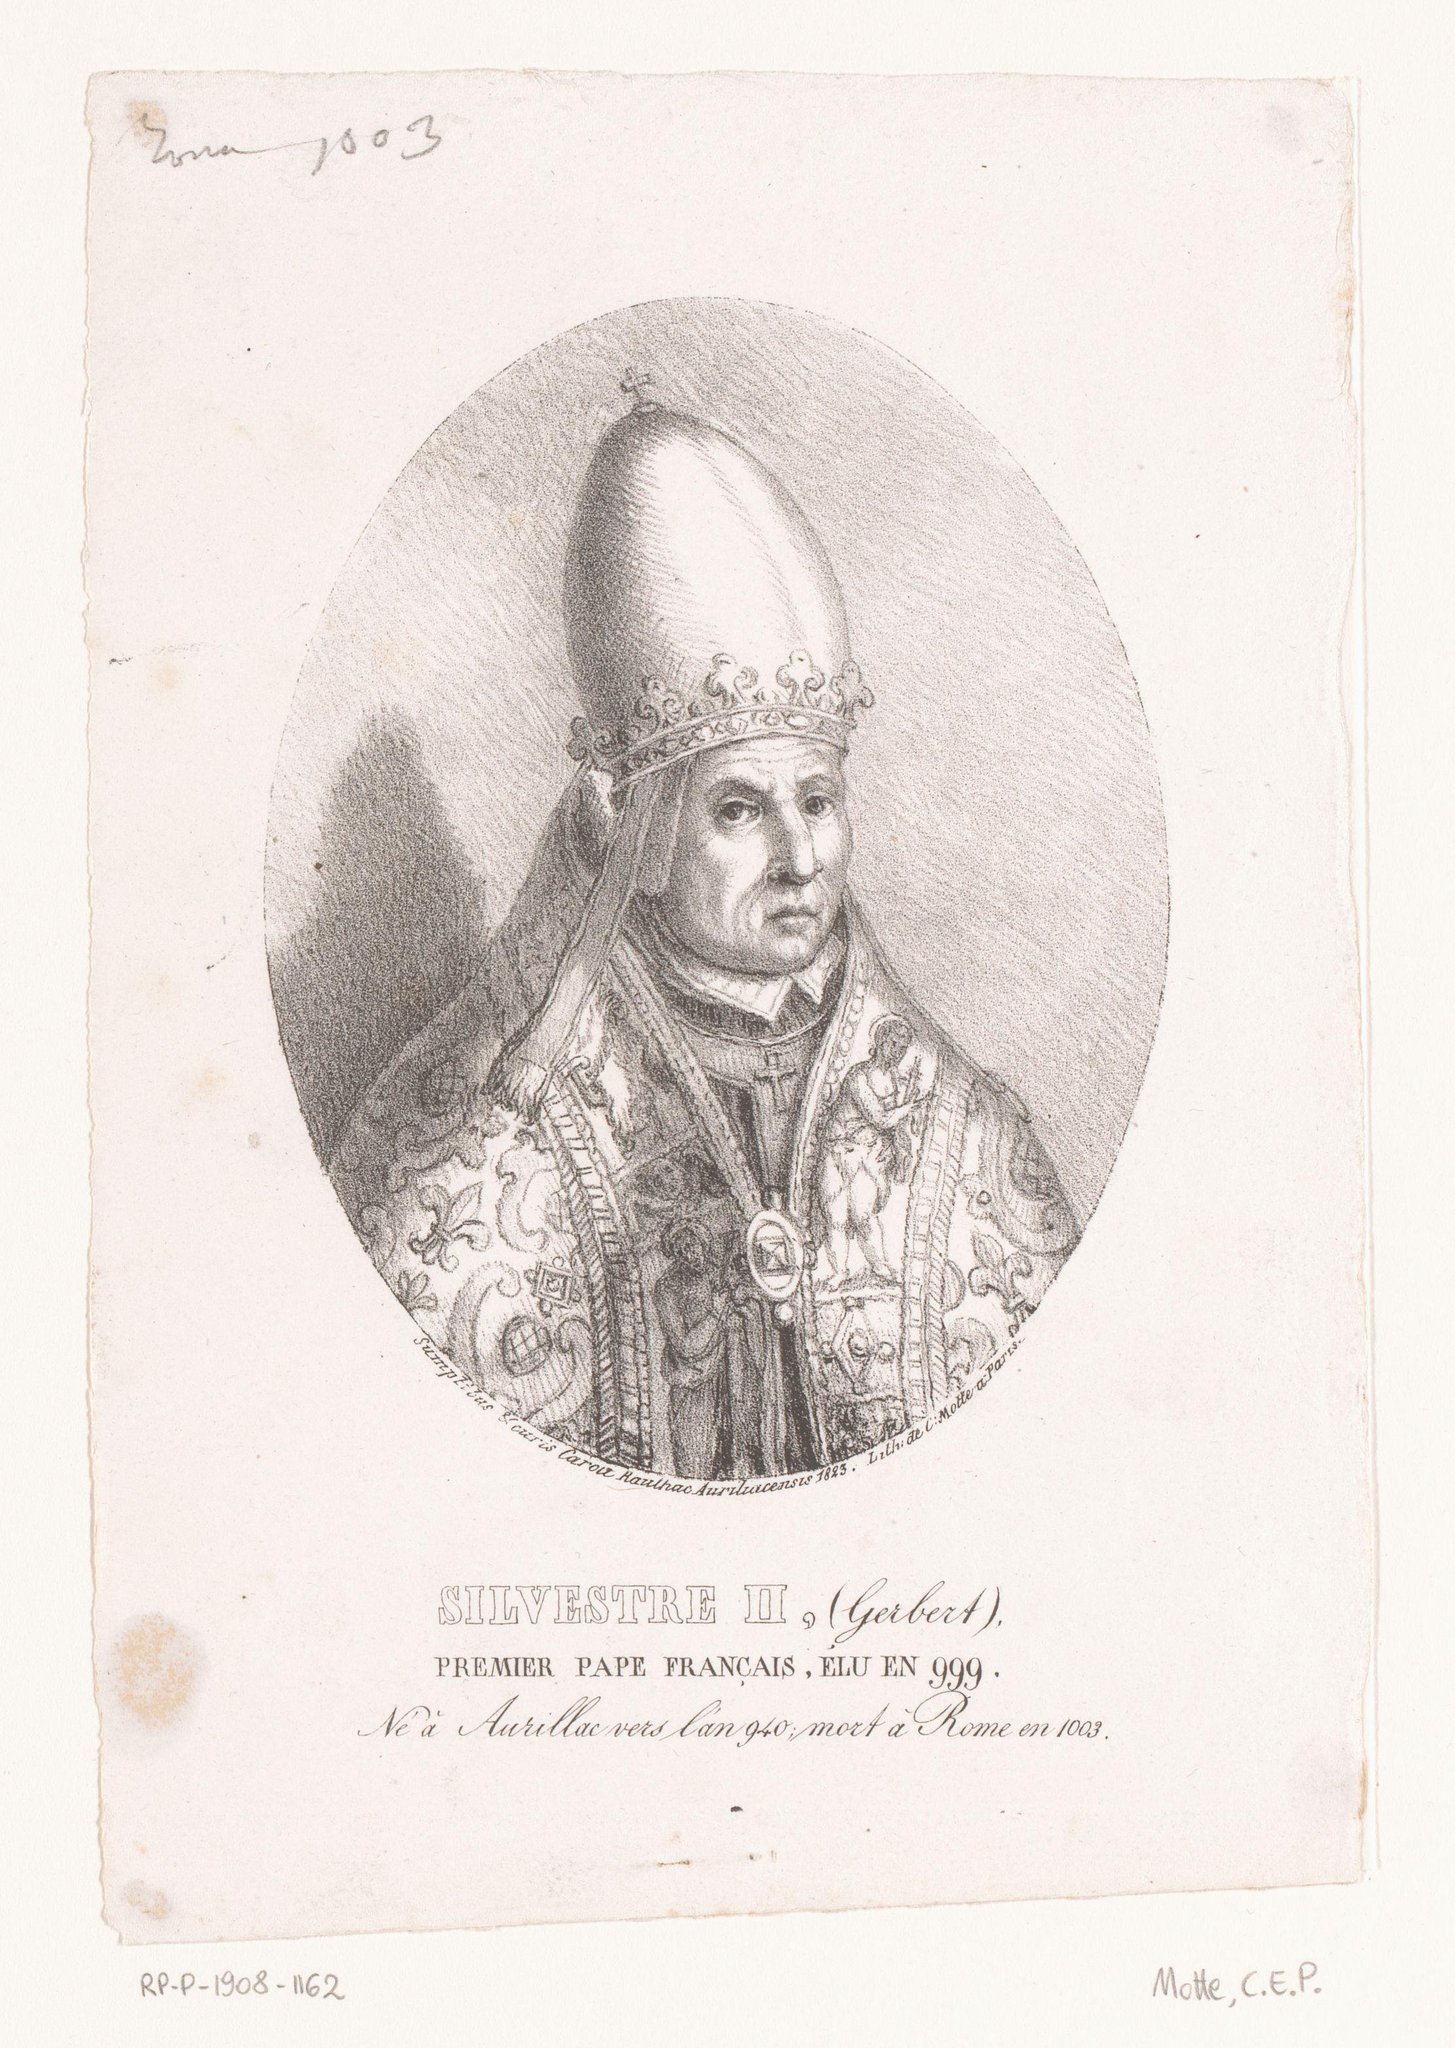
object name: print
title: Portret van paus Silvester II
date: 1823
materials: paper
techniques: lithograph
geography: paris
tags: historical persons, pope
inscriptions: collector's mark: Lugt 2228